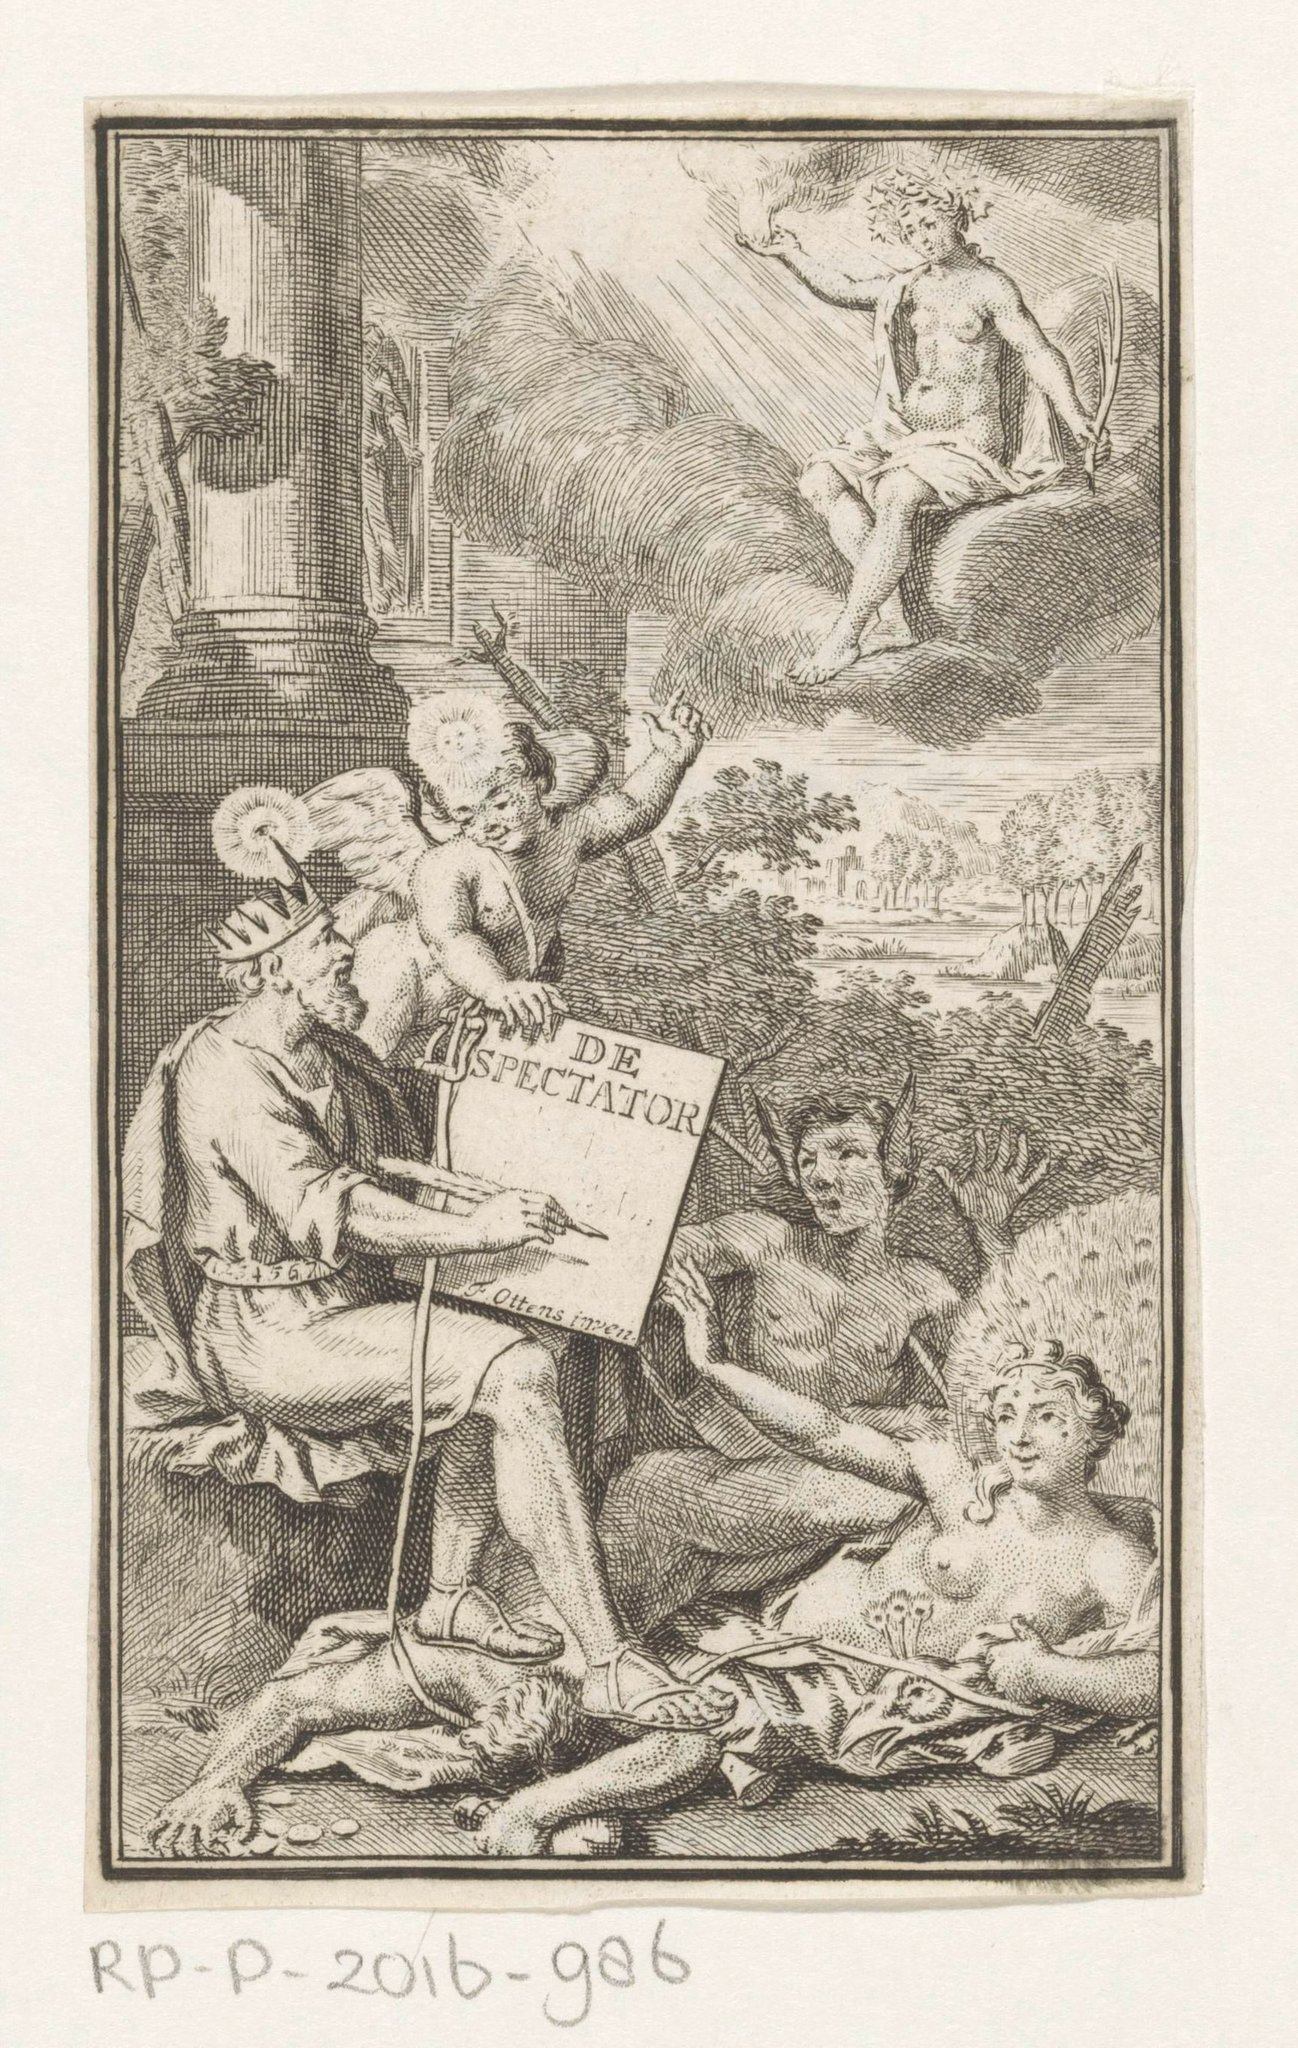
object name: titelblad, titelpagina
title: Titelpagina voor: Joseph Addison en Richard Steele, De spectator, of verrezene Socrates, s.a.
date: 1731-1743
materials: paper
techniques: engraving, etching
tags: crown (symbol of sovereignty), sitting figure, trampling, treading, stamping on someone or something, cupids: 'amores', 'amoretti', 'putti'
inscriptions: collector's mark: Lugt 2228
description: Titelpagina voor: Addison, Joseph en Steele, Richard. De spectator, of verrezene Socrates. [Mogelijk] Amsterdam: Uytwerf, Hermanus, s.a. Eerste druk van de Nederlandse vertaling kwam uit van 1720 tot 1727 in zes delen. Titelpagina onder andere gebruikt voor tweede druk, 1731 (deel 5) en derde druk, 1743 (deel 2, 5 en 6). Prent afkomstig uit een plakalbum met titelprenten, ornamenten etc. op blauw papier in 1983 uit elkaar gehaald.